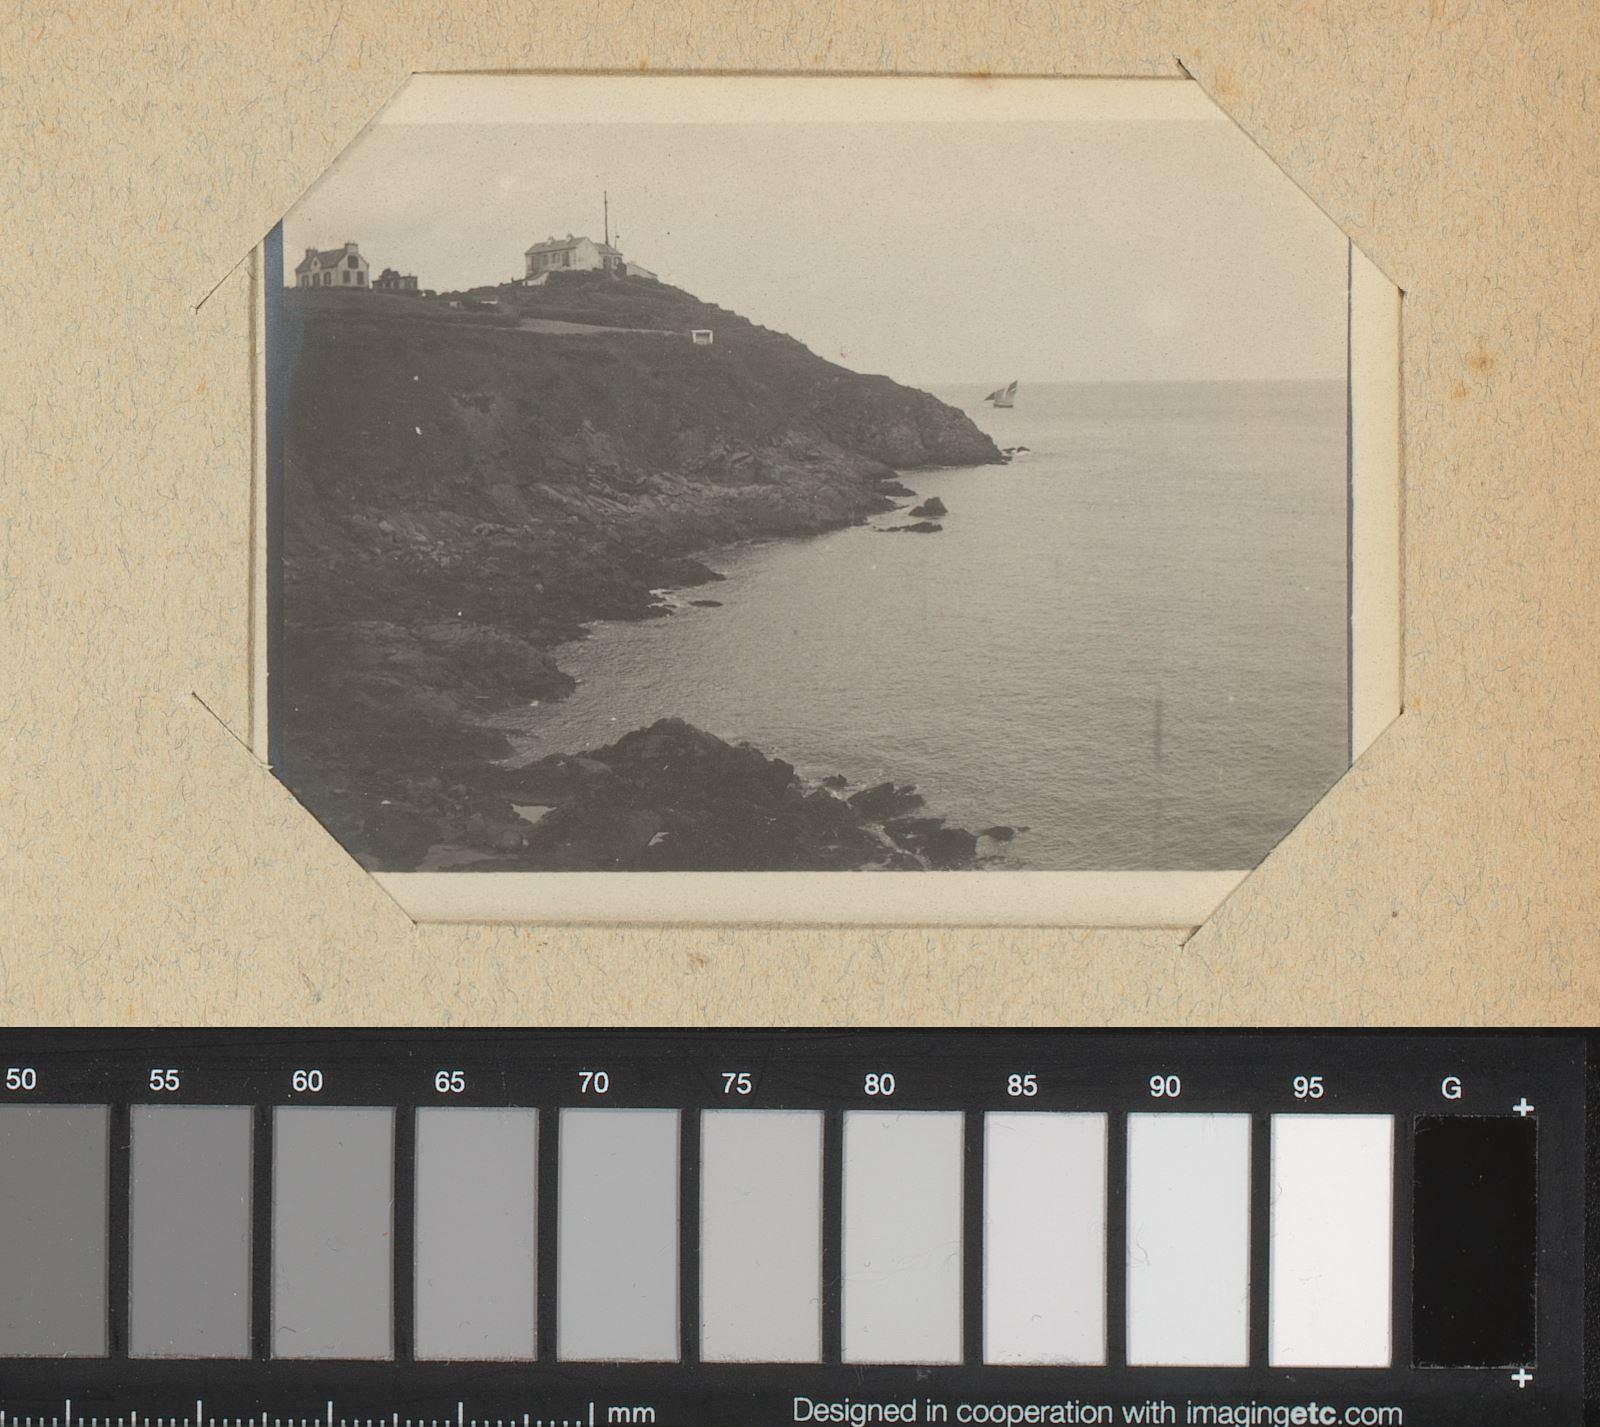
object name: album leaf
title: Huizen aan een rotskust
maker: Anonymous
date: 1897-1900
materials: paper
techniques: gelatin silver print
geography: france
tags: rocky coast, france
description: Over de foto is een ander negatief afgedrukt van een voorstelling van bomen.